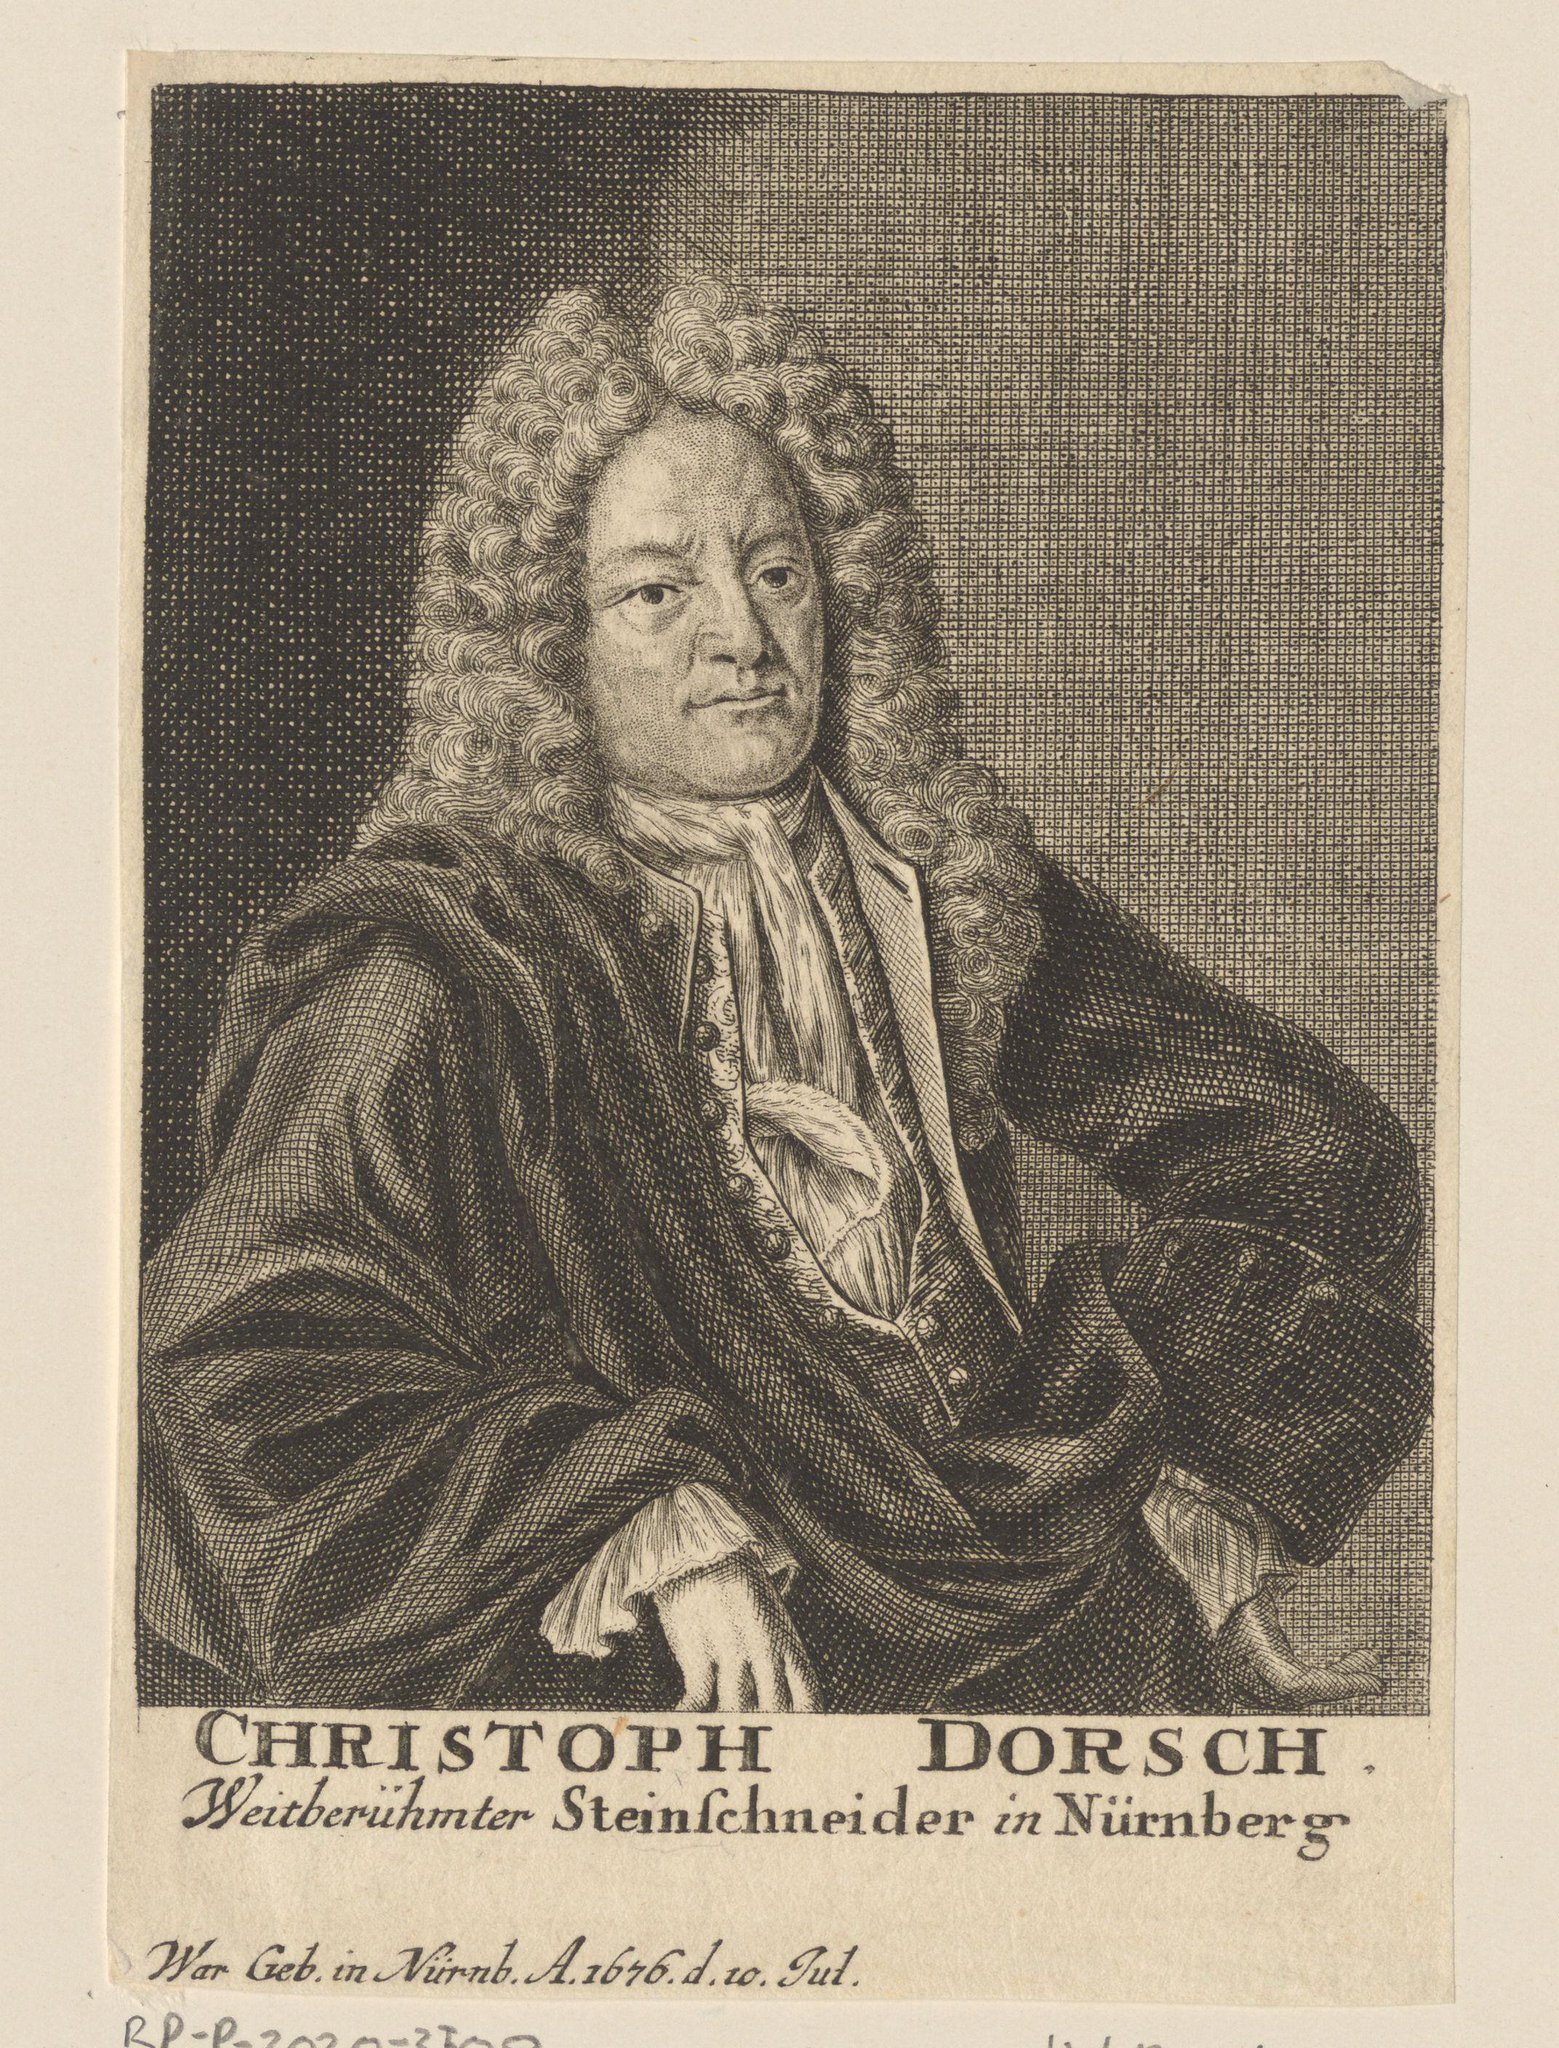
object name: print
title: Portret van Christoph Dorsch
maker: wolfgang philipp kilian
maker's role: artist, draughtsman, print maker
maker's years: 1654-1732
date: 1696-1732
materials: paper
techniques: engraving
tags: stone-cutter, stone-sawyer, historical persons